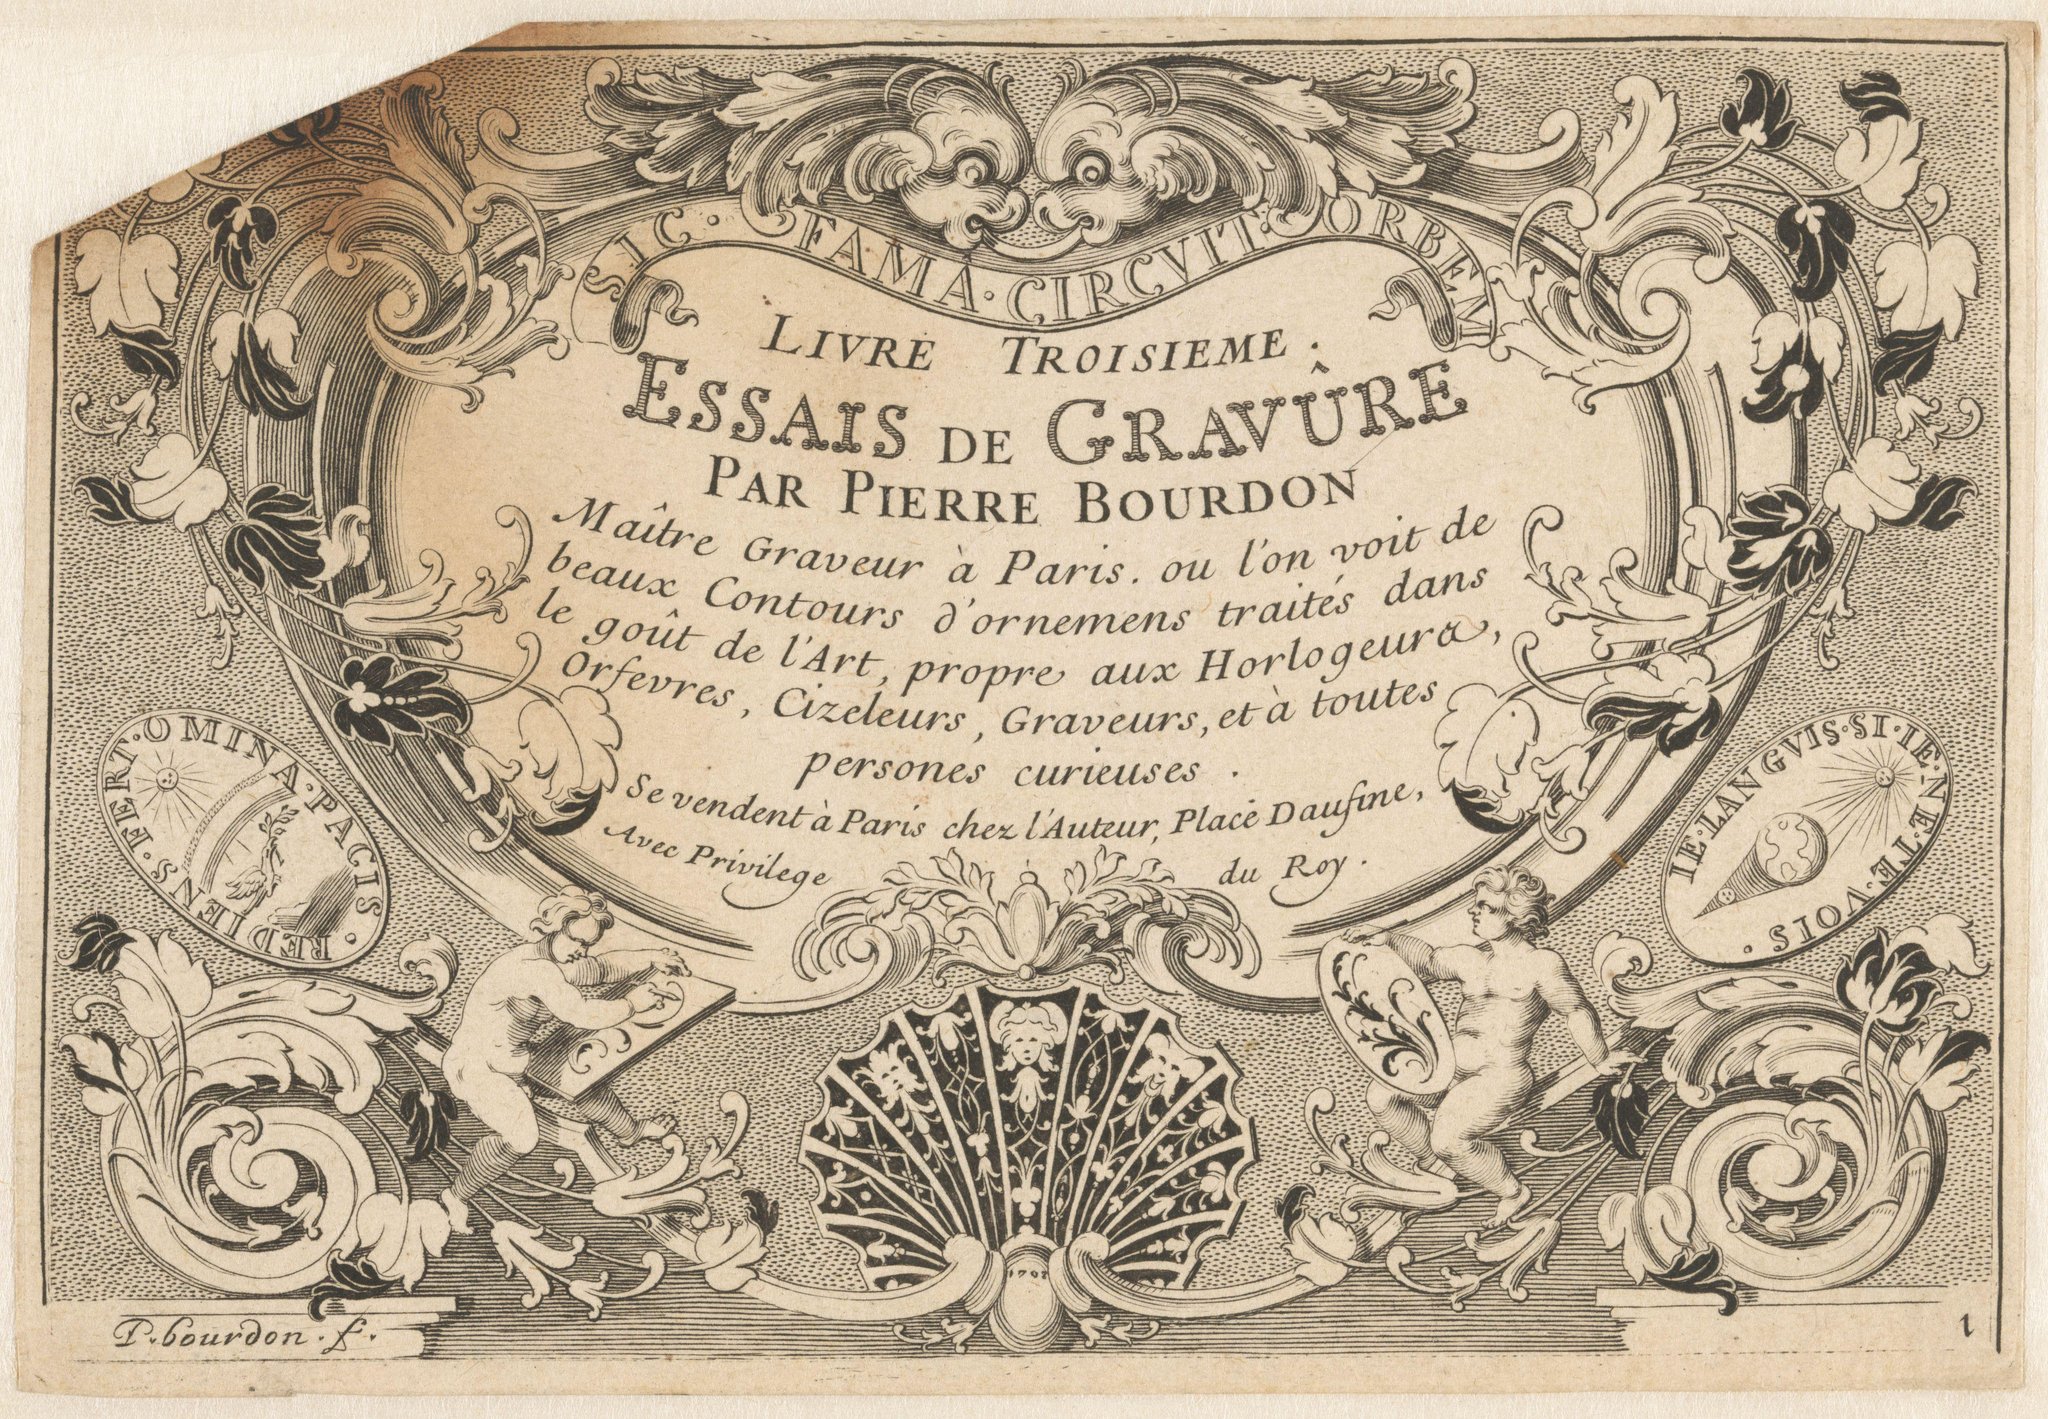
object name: titelprent, frontispice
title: Livre Troisieme: Essais de gravure par Pierre Bourdon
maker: pierre bourdon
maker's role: print maker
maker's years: 1656-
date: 1703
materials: paper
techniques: engraving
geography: paris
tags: ornaments ~ art, title-page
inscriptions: collector's mark: Lugt 2760, signature: ‘P. bourdon f.’, collector's mark: Lugt 2228, privilege: ‘Avec Privilege du Roy’, number: ‘1’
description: Titelprent van serie van zeven van ontwerpen voor horlogemakers, goudsmeden, beeldhouwers en graveurs.